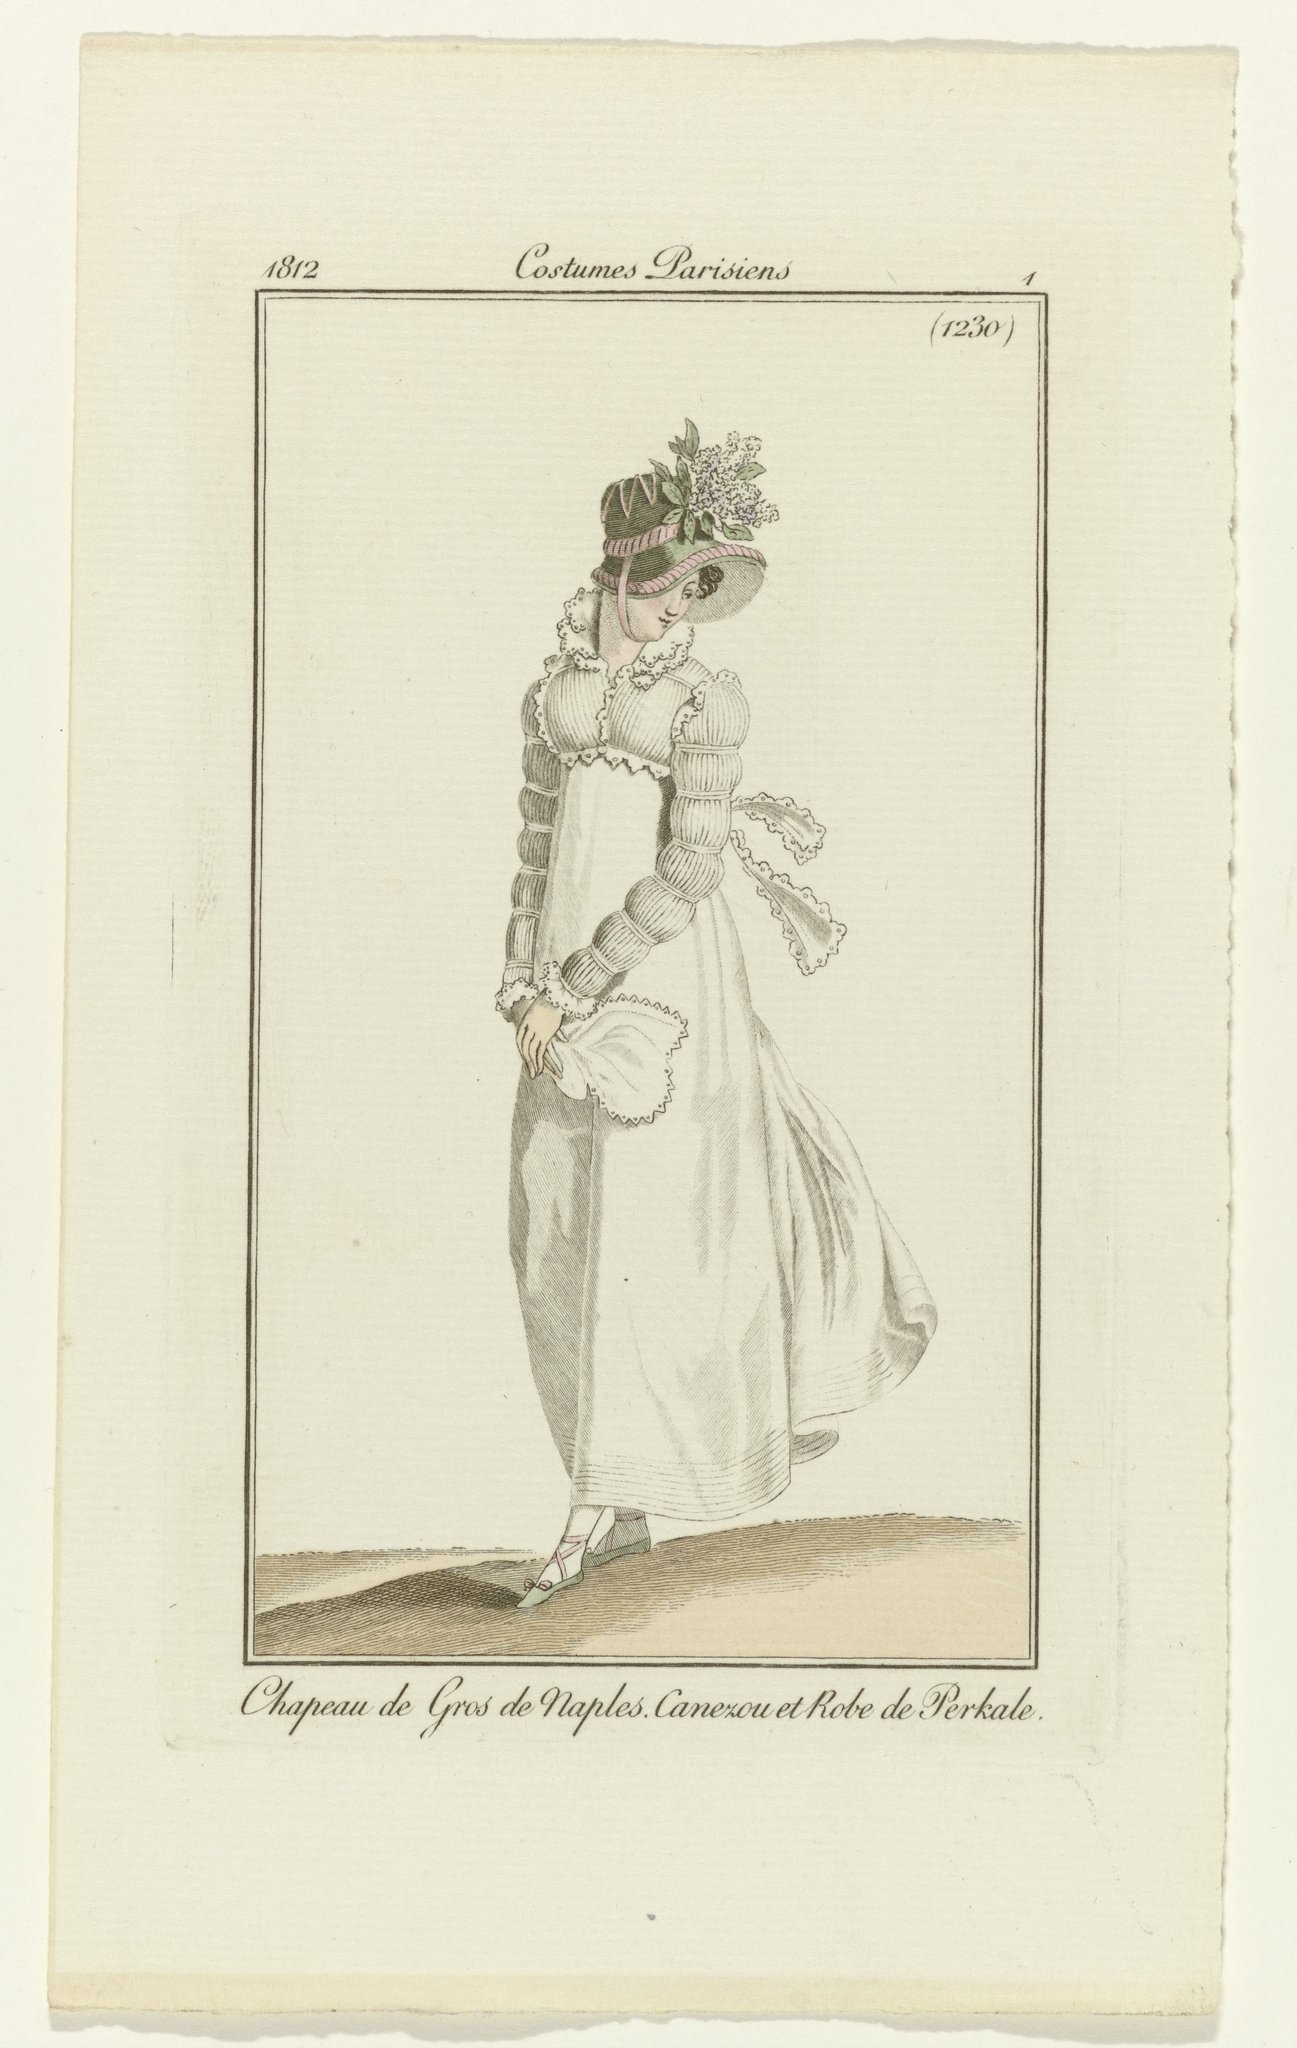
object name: fashion print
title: Journal des Dames et des Modes, Costumes Parisiens, kopie naar 25 mai 1812, (1230), No. 1: Chapeau de Gros de Naples (...)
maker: Anonymous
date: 1912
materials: paper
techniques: engraving, hand coloring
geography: paris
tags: handkerchief (+ women's clothes), fashion plates, head-gear: hat (+ women's clothes), shoes, sandals (+ women's clothes), dress, gown (+ women's clothes)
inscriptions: title: ‘Costume Parisiens.’, caption: ‘Chapeau de Gros de Naples. Canezou et Robe Perkale.’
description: Vrouw, lopend naar links, gekleed in een canezou en japon van katoenbatist (percale). Op het hoofd een hoed van 'gros de Naples'. Verdere accessoires: zakdoek, platte schoenen met gekruiste banden. Prent No. 1230 uit het modetijdschrift Journal des Dames et des Modes (1797-1839). uitgegeven door Pierre de la Mésangère, Parijs, 1797-1839. Hier gepresenteerd als prent No. 1 in het modetijdschrift Journal des Dames et des Modes (1912-1914).